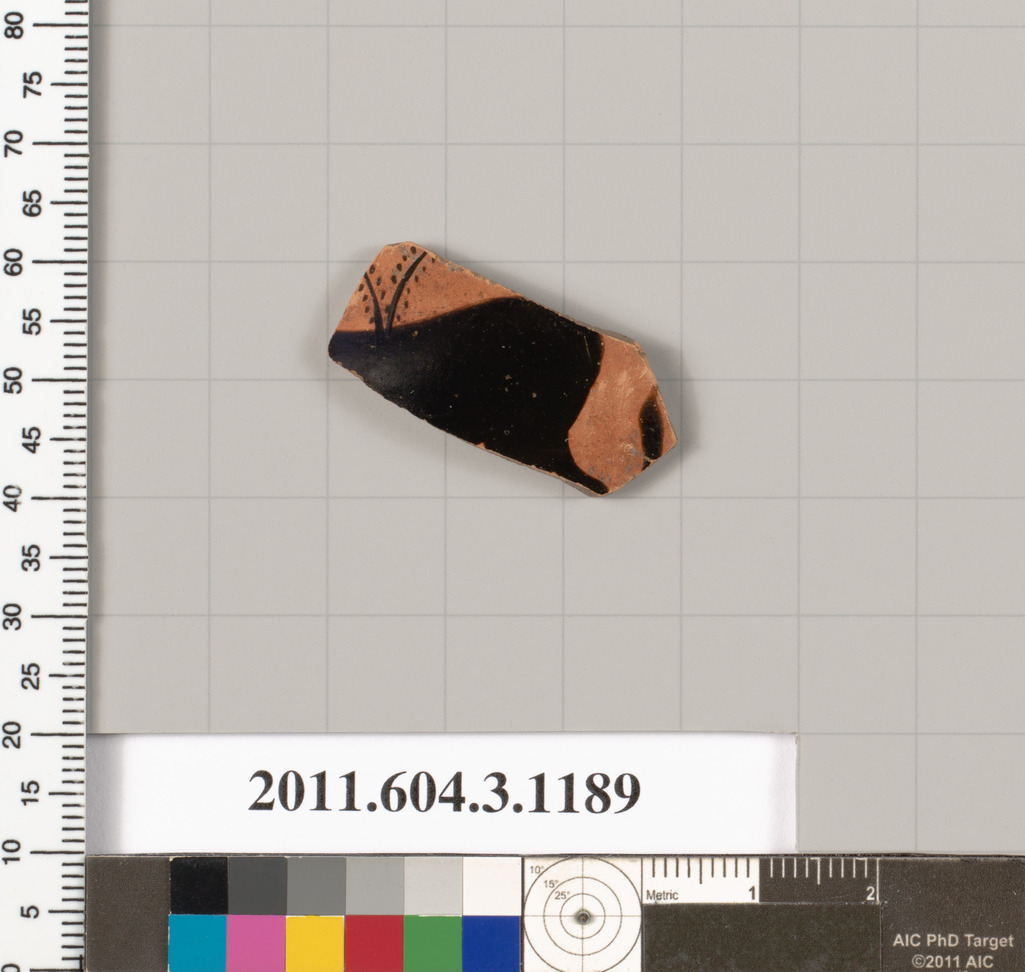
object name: mastoid fragment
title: Terracotta fragment of a mastoid (drinking cup with narrow base)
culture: greek, attic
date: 534-468 BCE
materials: terracotta